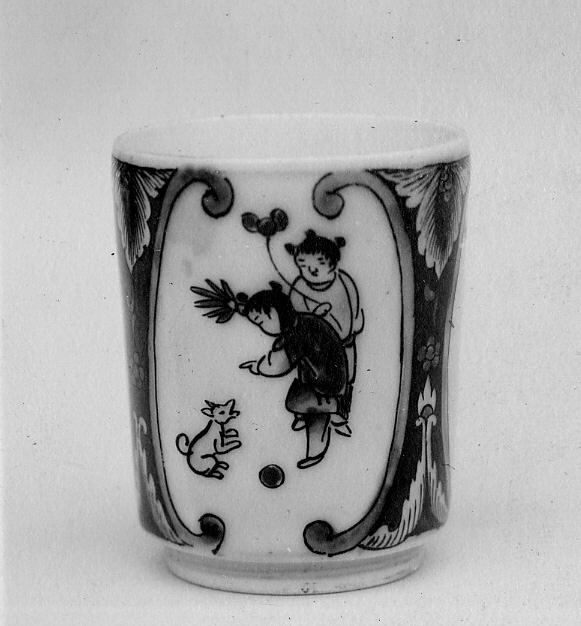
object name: cup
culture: japanese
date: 1780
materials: enamel, porcelain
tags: children,playing